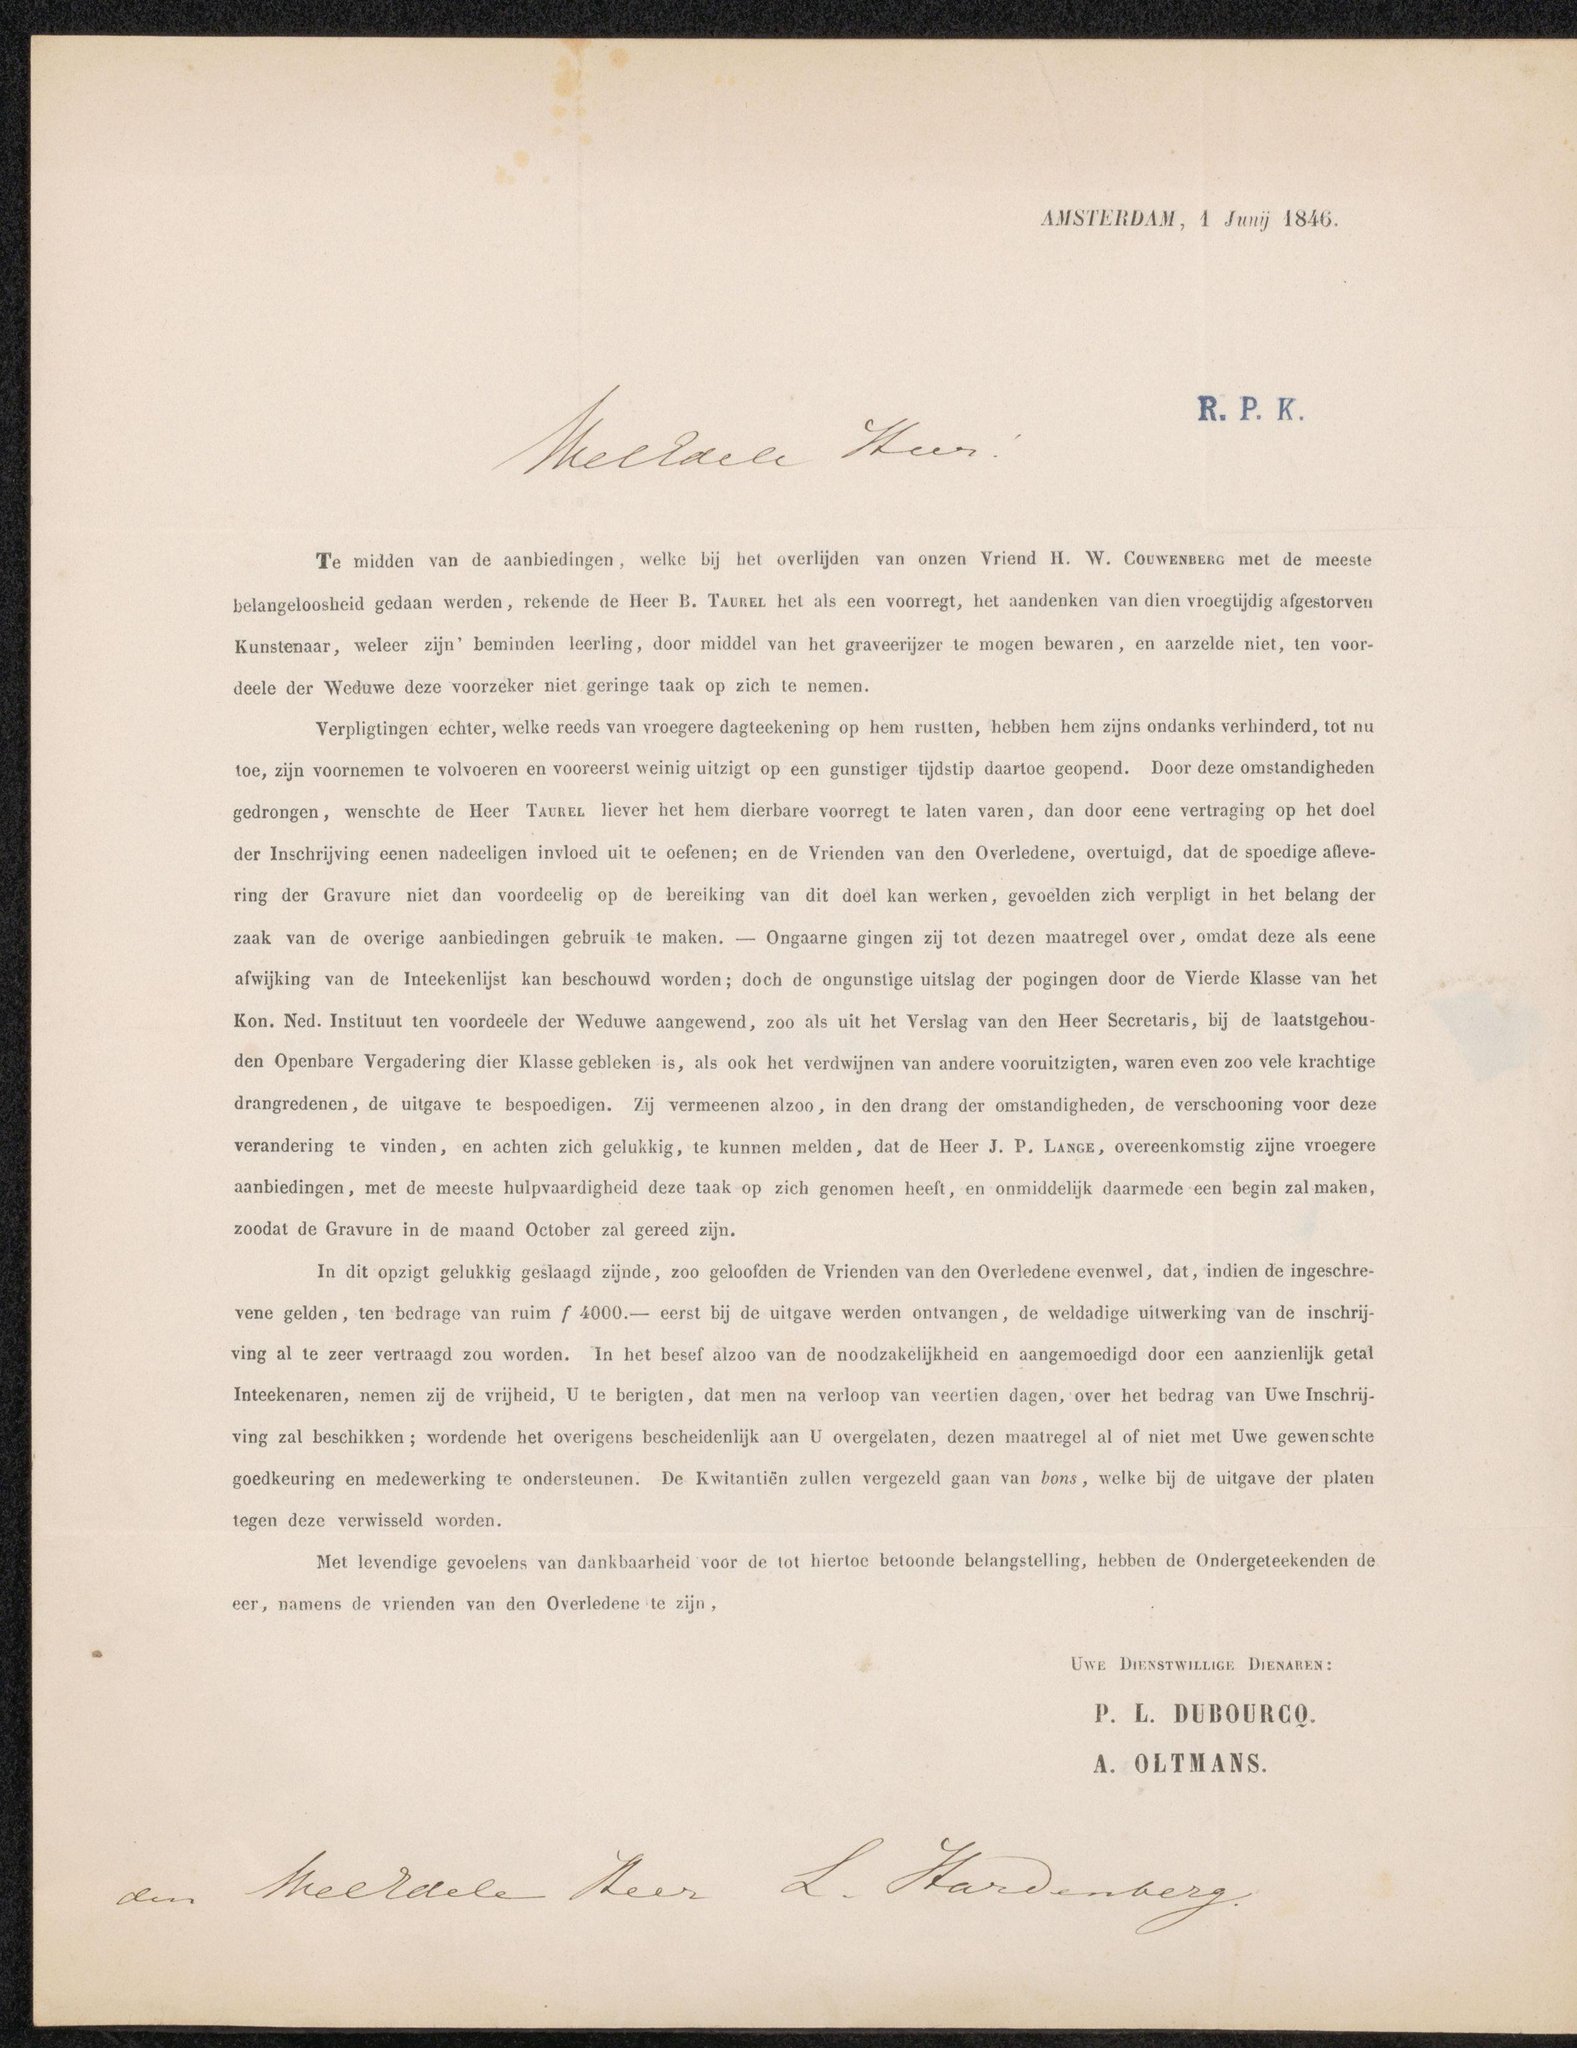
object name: letter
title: Brief aan Lambertus Hardenberg (1822-1900)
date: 1846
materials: ink, paper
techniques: pen, printing, writing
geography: amsterdam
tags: benoit taurel, johannes philippus lange, painter, lambertus hardenberg (1822-1900), the hague, amsterdam, print maker, draughtsman, henricus wilhelmus couwenberg, the graphic arts, money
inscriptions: collector's mark: Lugt 2233